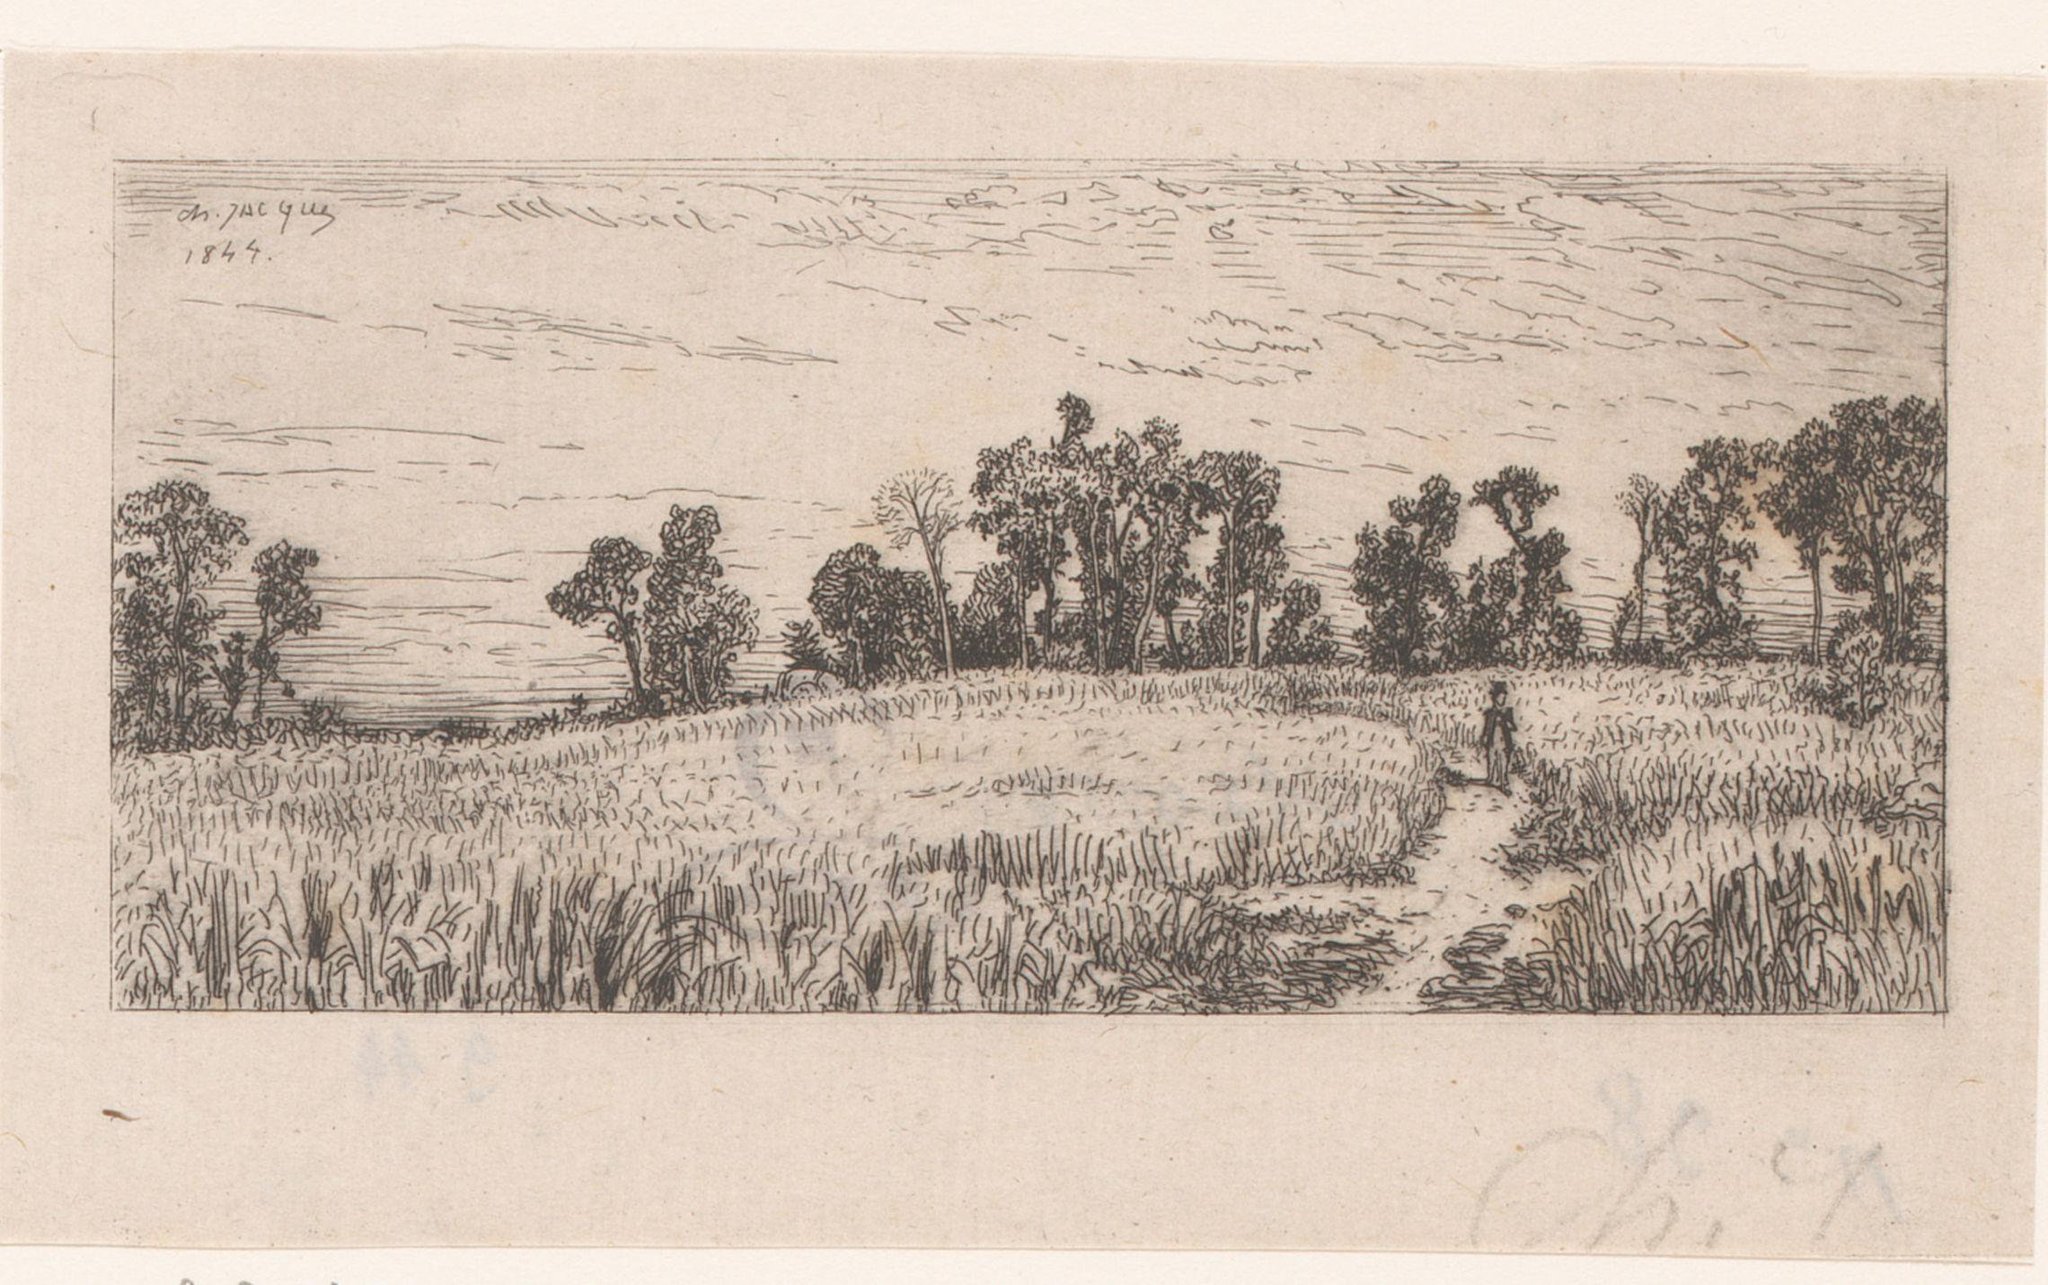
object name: print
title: Korenveld met een figuur op een pad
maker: charles emile jacque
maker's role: draughtsman, painter, print maker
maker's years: 1813-1894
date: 1844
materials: paper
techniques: etching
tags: road, path, cereal, grain, corn (grass with grains, grown for food, e.g.: wheat, rice, rye, oats, maize, buckwheat, millet)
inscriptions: collector's mark: Lugt 964